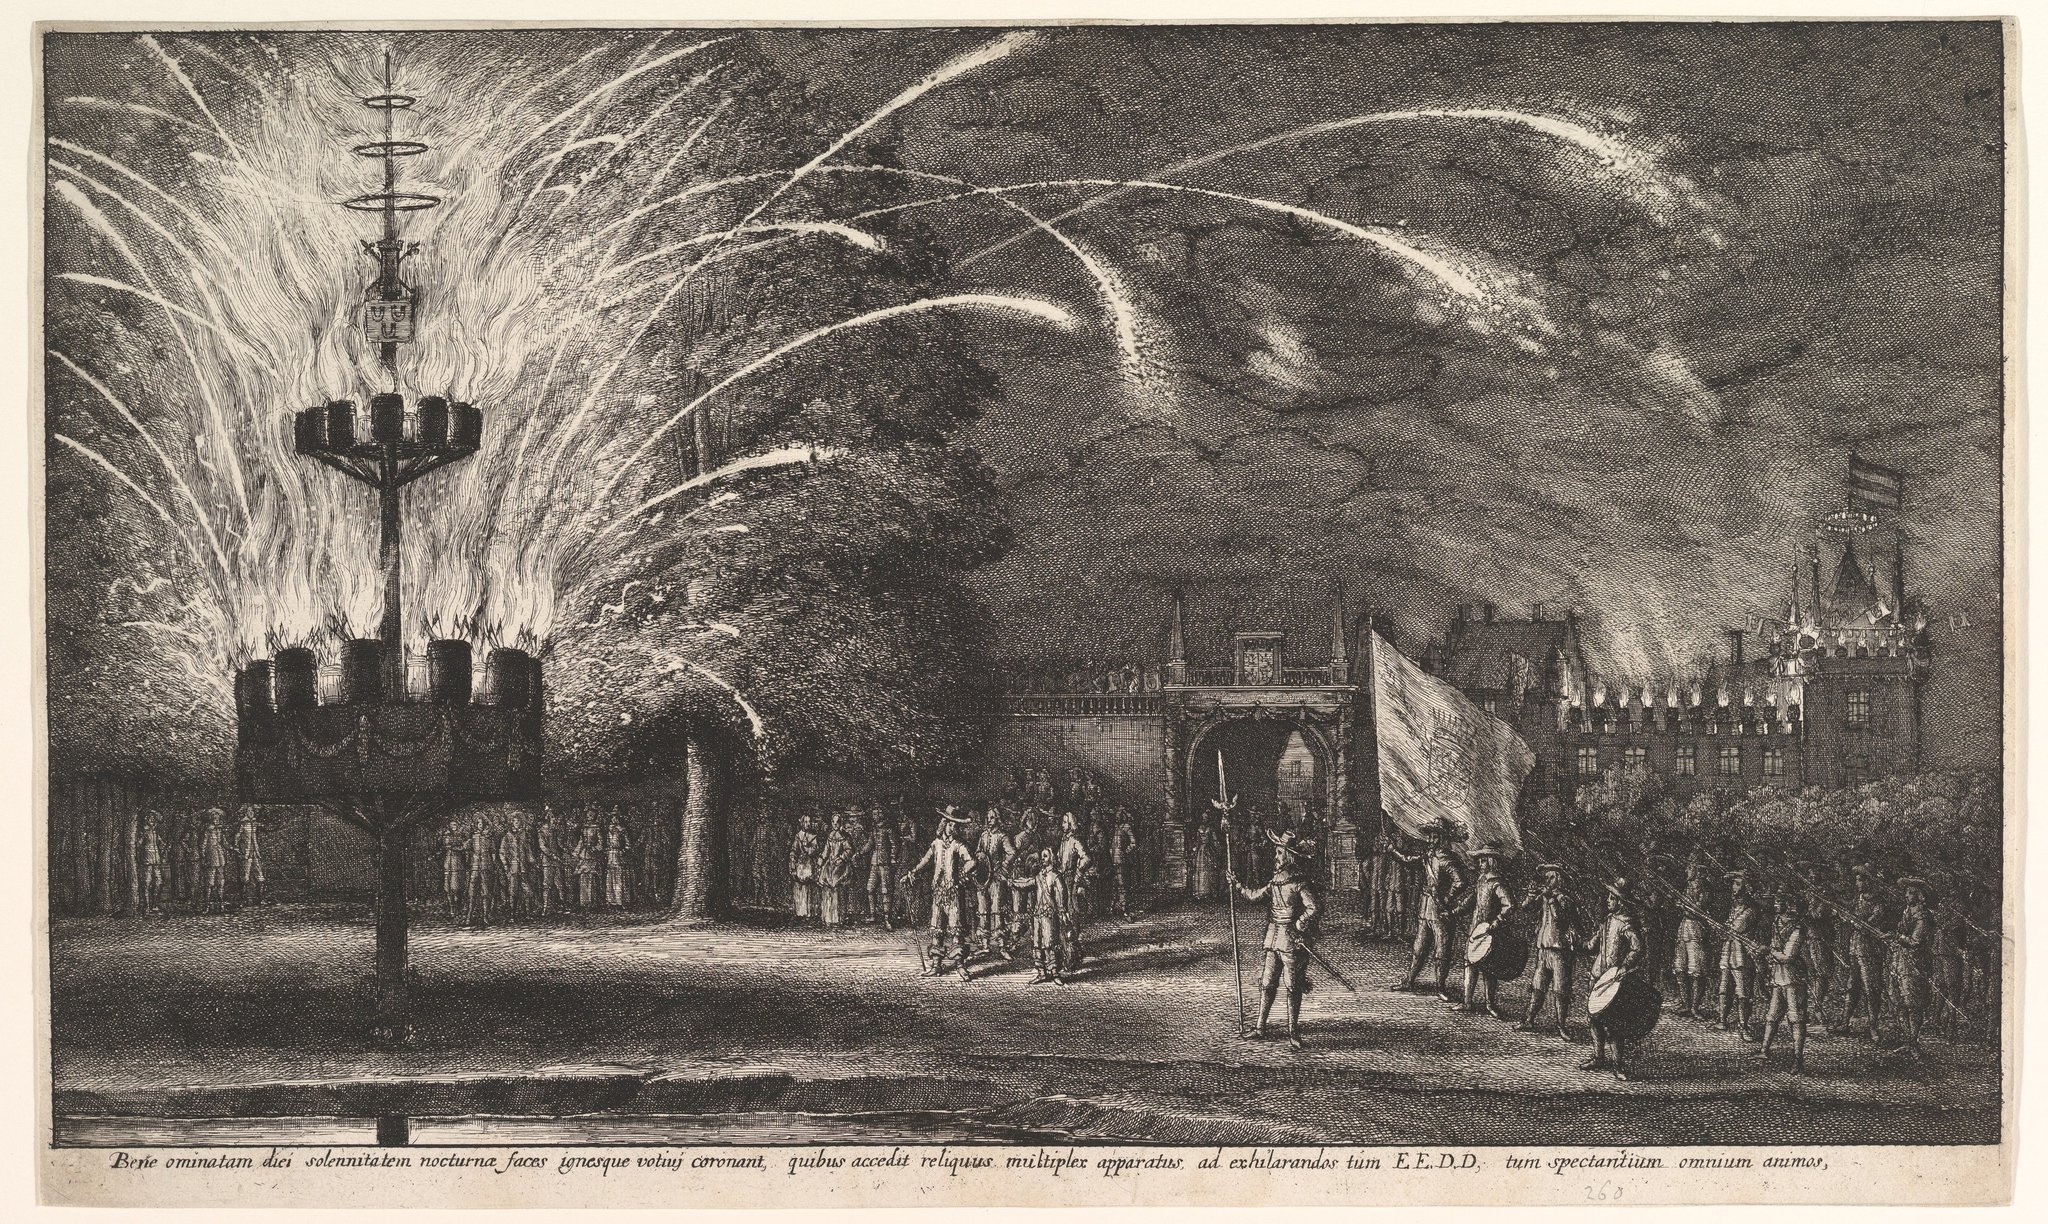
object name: print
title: Fireworks at Hemissem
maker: wenceslaus hollar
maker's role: artist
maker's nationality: bohemian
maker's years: 1607-1677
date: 1650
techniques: drypoint, etching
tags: castles,fireworks,crowd